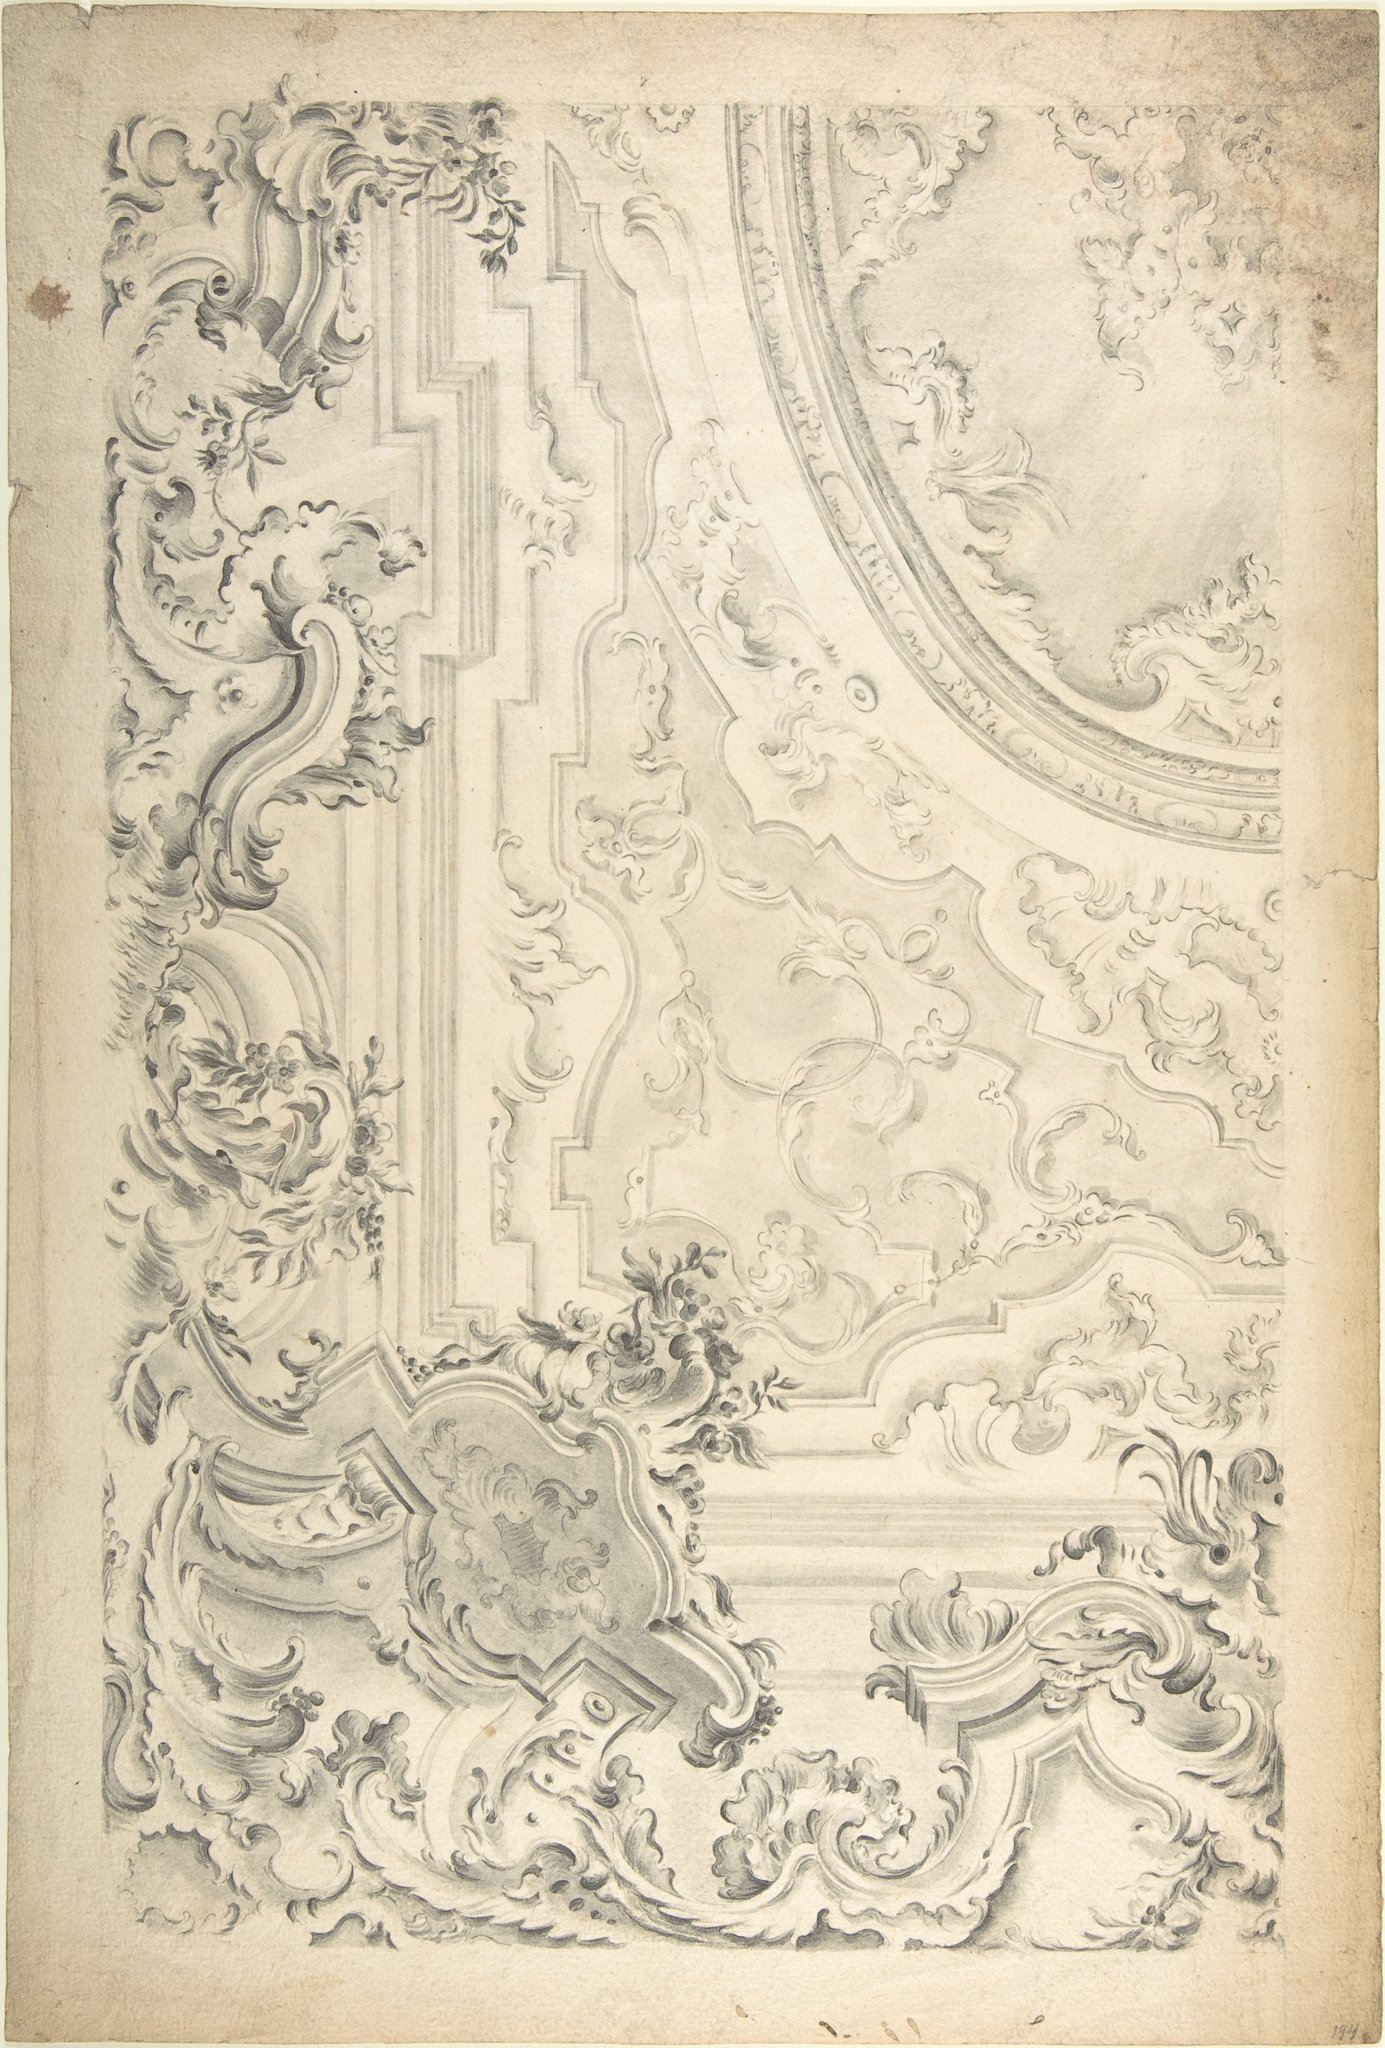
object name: drawing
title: Design for a Ceiling with Cove Showing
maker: anonymous, italian, piedmontese, 18th century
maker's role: artist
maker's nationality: italian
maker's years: 1700-1800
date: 1700-1780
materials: chalk, drawing material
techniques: brush, wash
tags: ornament,coat of arms